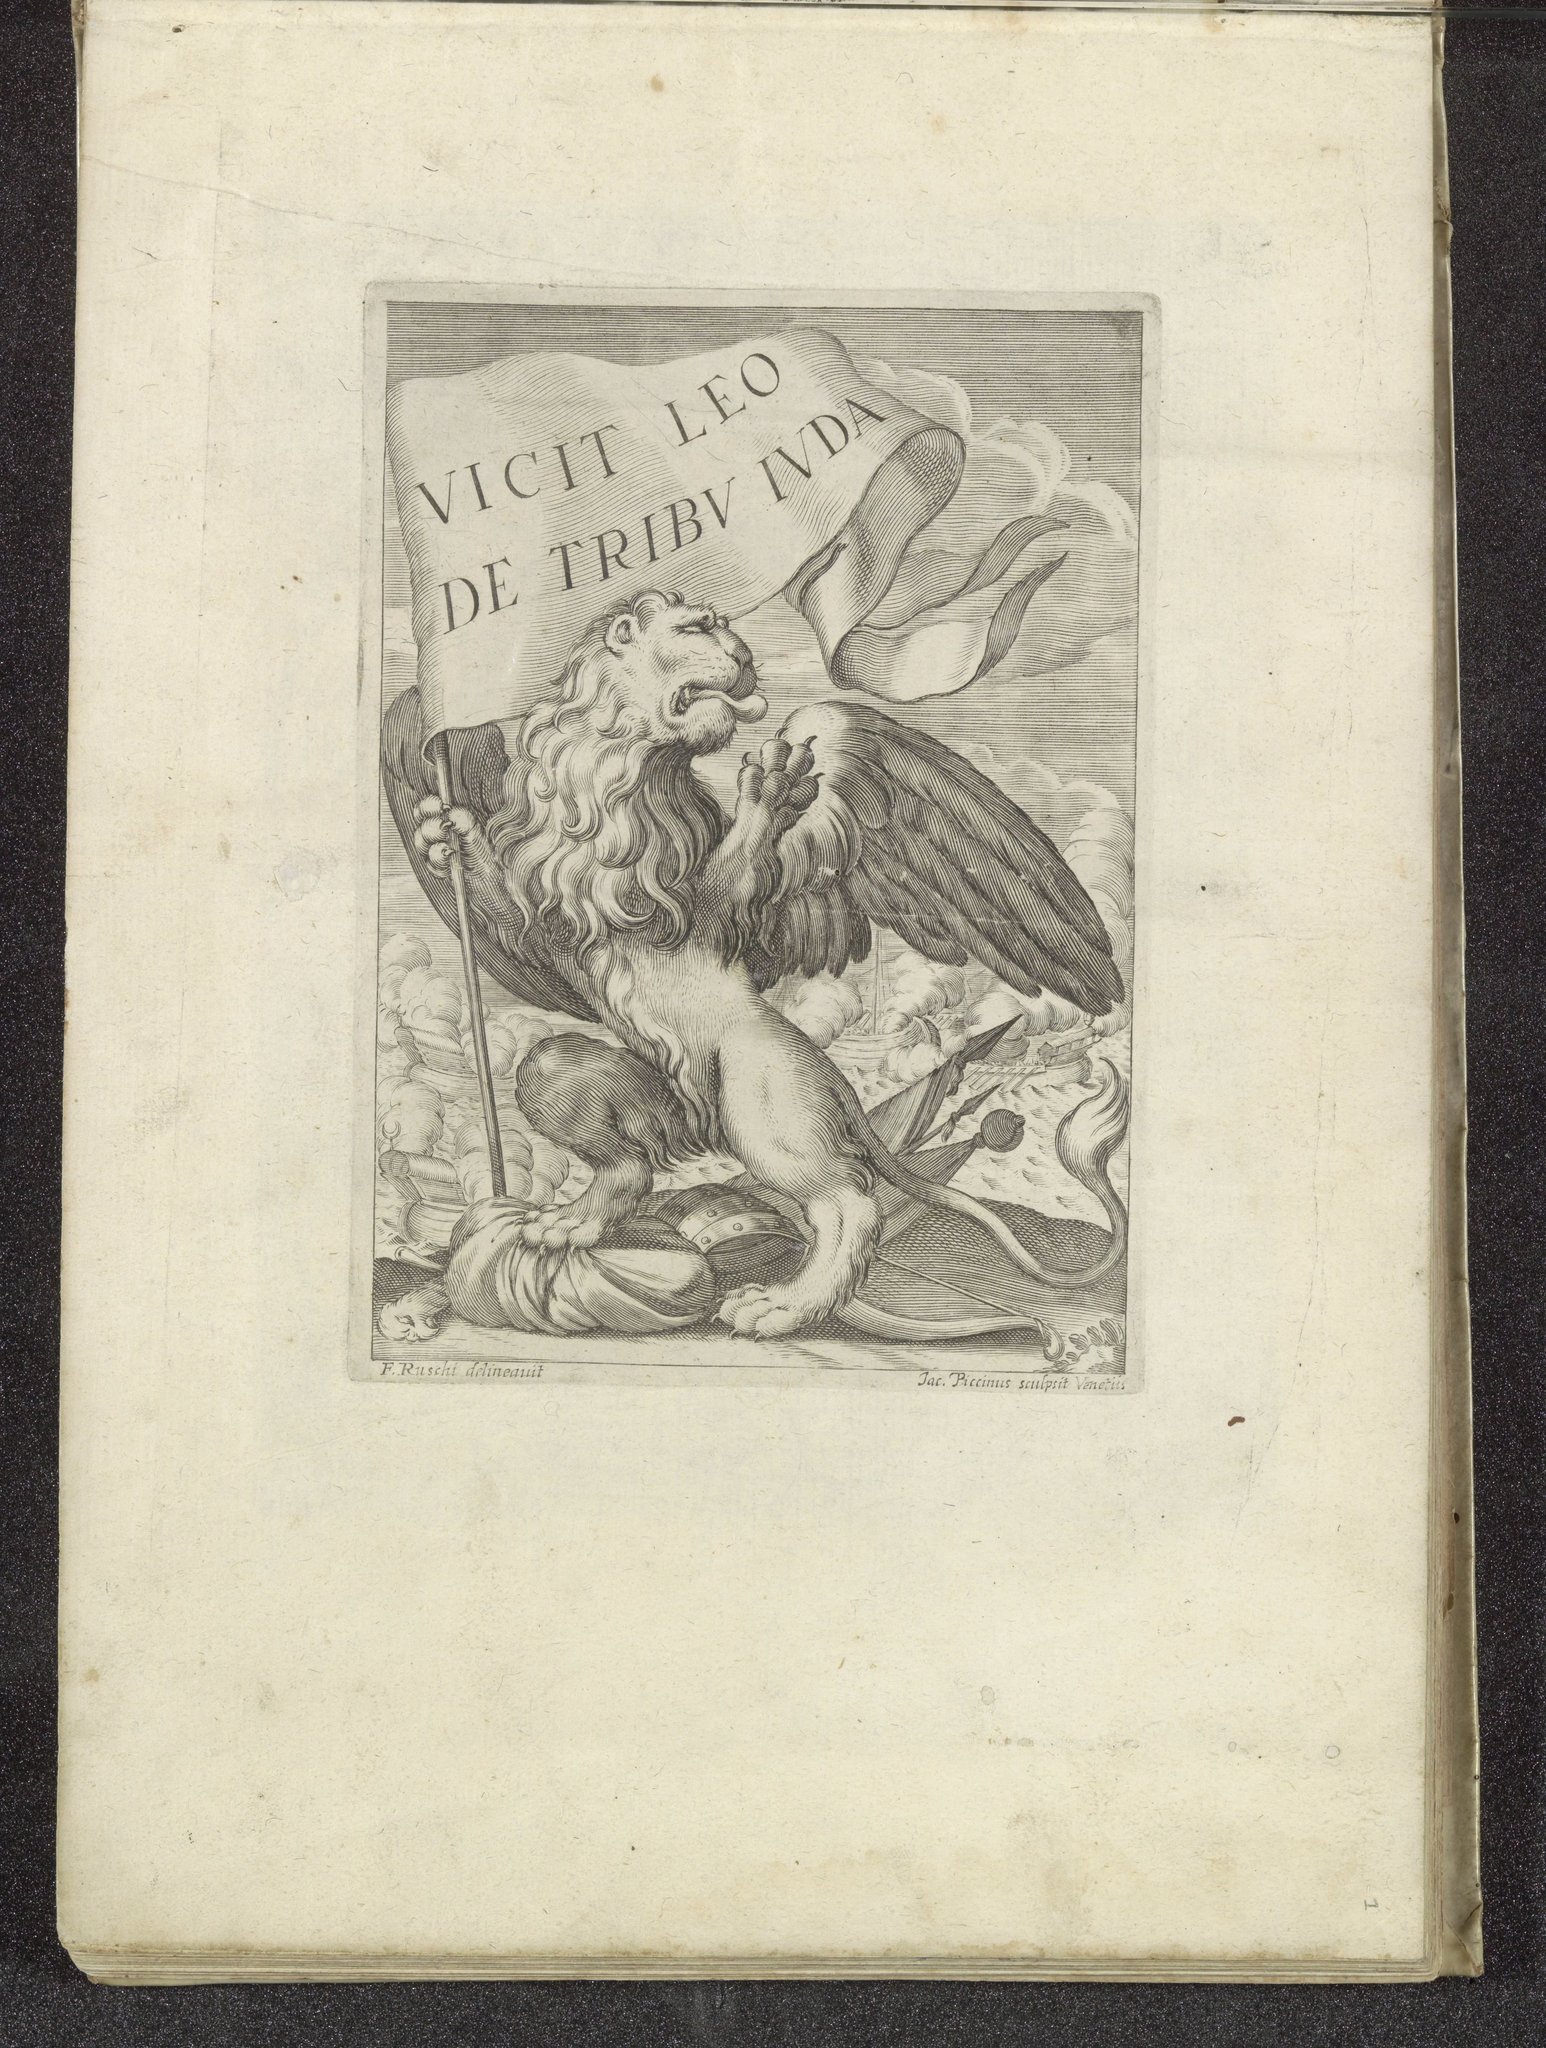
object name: print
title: Allegorische voorstelling met een leeuw met banier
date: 1627-1669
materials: paper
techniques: engraving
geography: italy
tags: weapons, beasts of prey, predatory animals: lion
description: Een leeuw staand op zijn achterpoten met in zijn rechter voorpoot een banier. Met zijn achterpoten vertrapt hij wapens. Op de achtergrond schepen in gevecht. De prent maakt deel uit van een album.